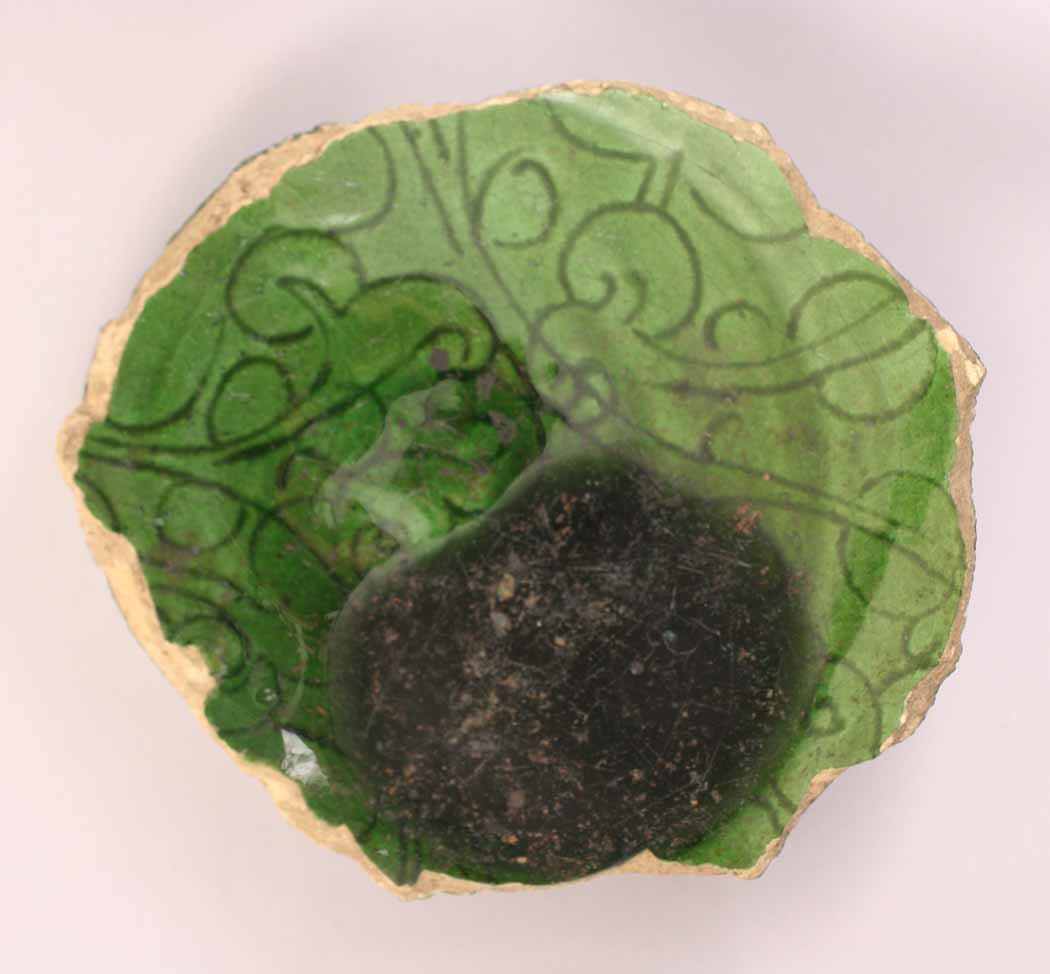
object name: ceramic fragment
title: Fragment of a Bowl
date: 1201-1400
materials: glaze, stonepaste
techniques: glazing, incising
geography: egypt